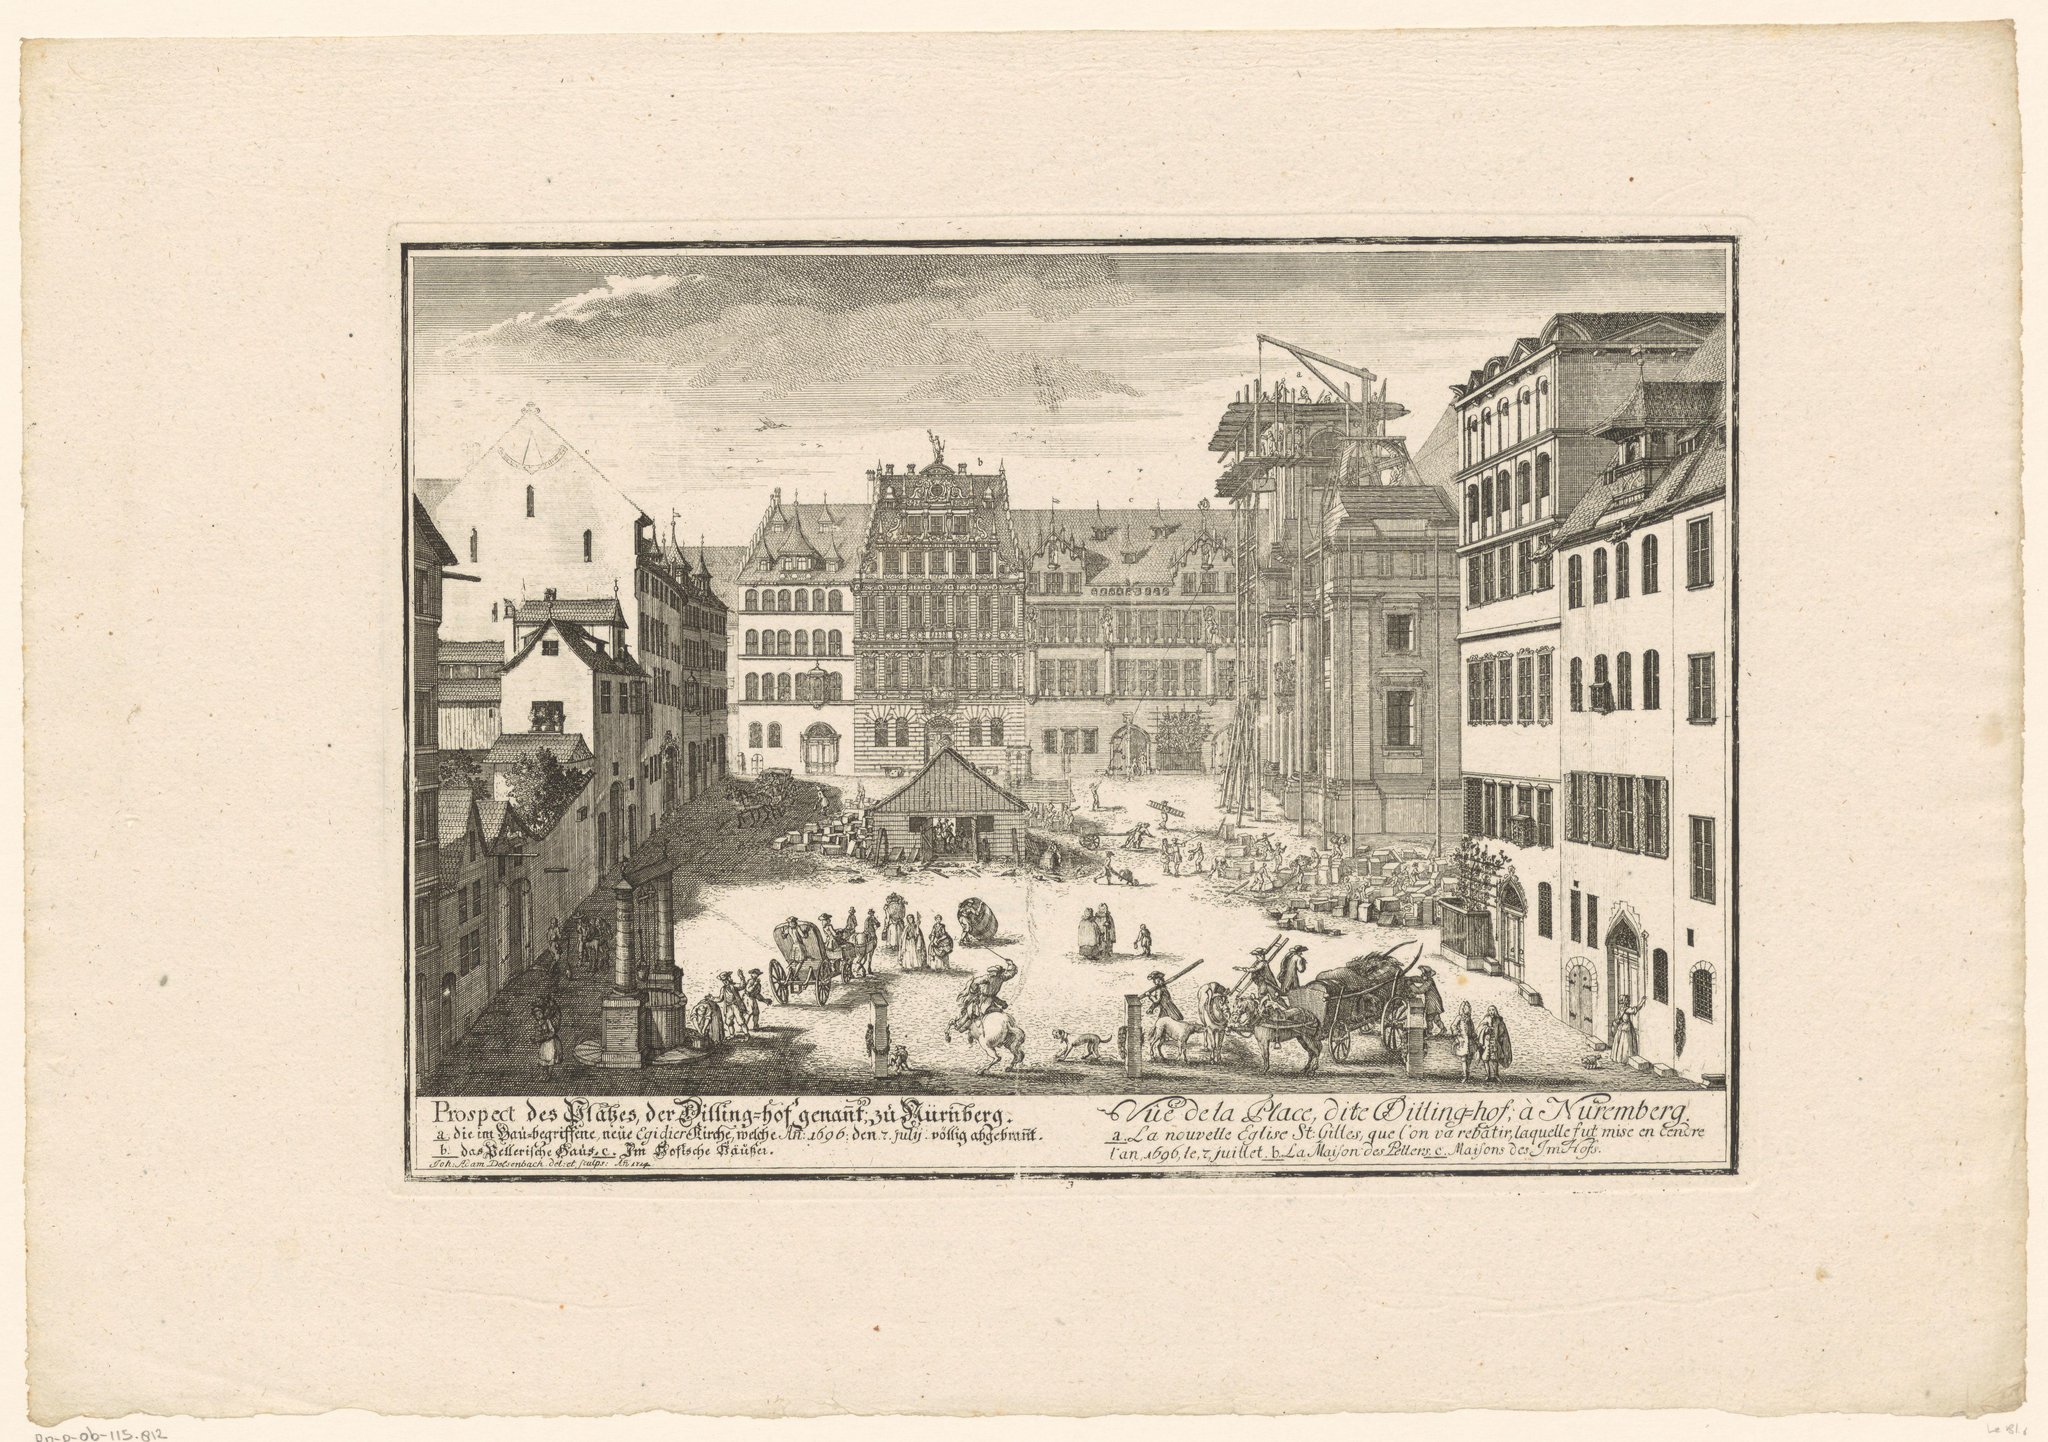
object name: print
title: Stadsgezichten van Neurenberg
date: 1714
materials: paper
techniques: etching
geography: nuremberg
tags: city-view in general; 'veduta', building of church, village square, place (+ city(-scape) with figures, staffage)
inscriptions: collector's mark: Lugt 2228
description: Deze prent behoort tot een serie van Neurenbergse stadsgezichten gemaakt door Johann Adam Delsenbach. Het Rijksmuseum heeft zestien prenten uit deze reeks in bezit, waarvan de laatste is voorzien van nummer 24. Het is onduidelijk uit hoeveel prenten de originele serie bestaat. Rechts op de prent is te zien hoe de St. Egidien kerk wordt herbouwd nadat deze in 1696 door brand werd verwoest.